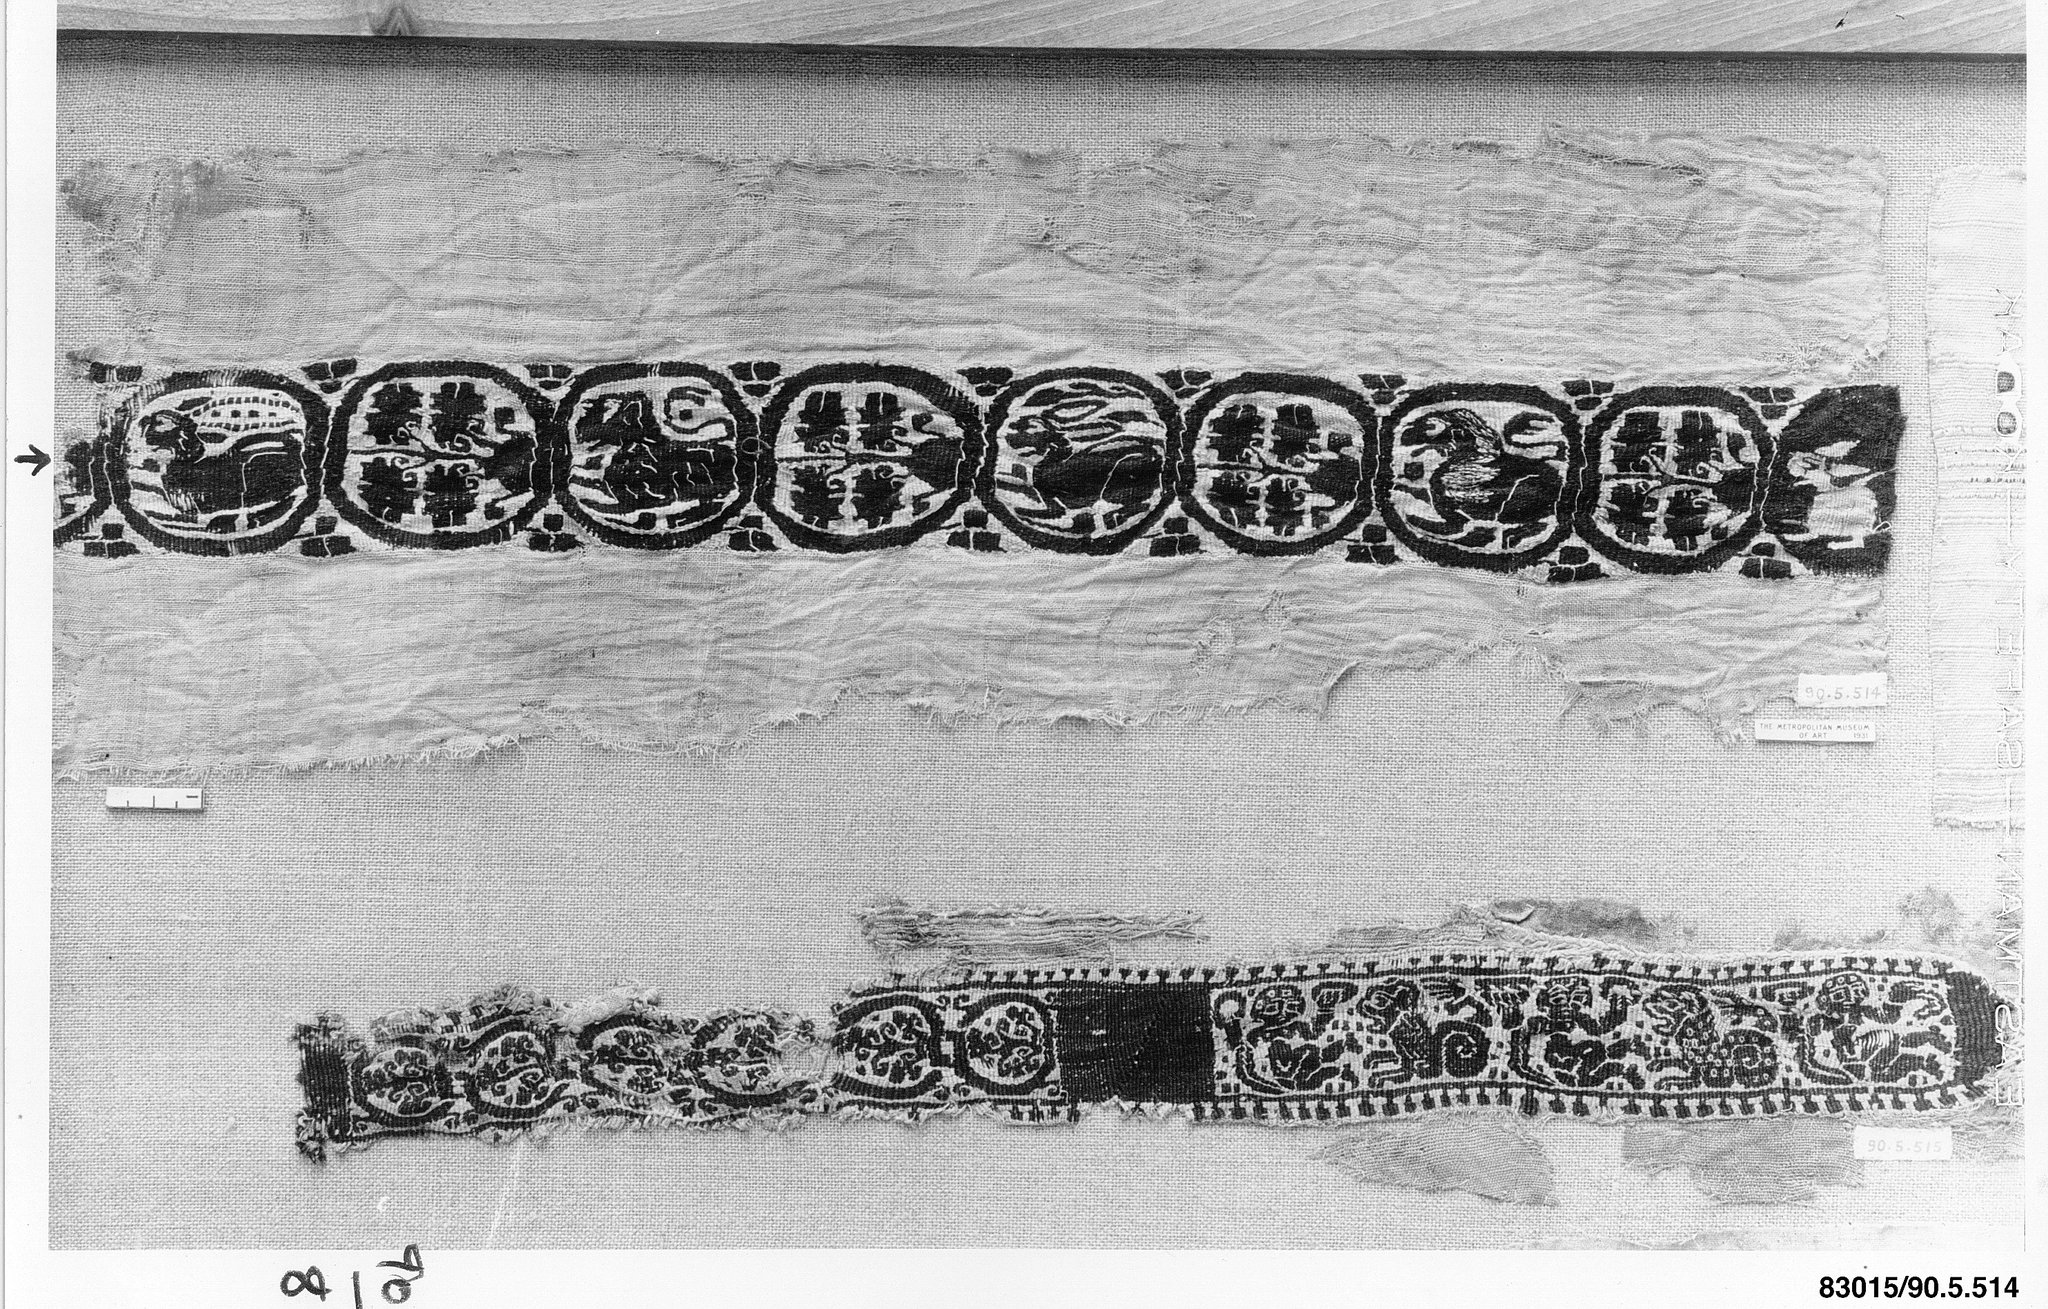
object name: textile fragment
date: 201-400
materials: linen, wool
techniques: weave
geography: egypt